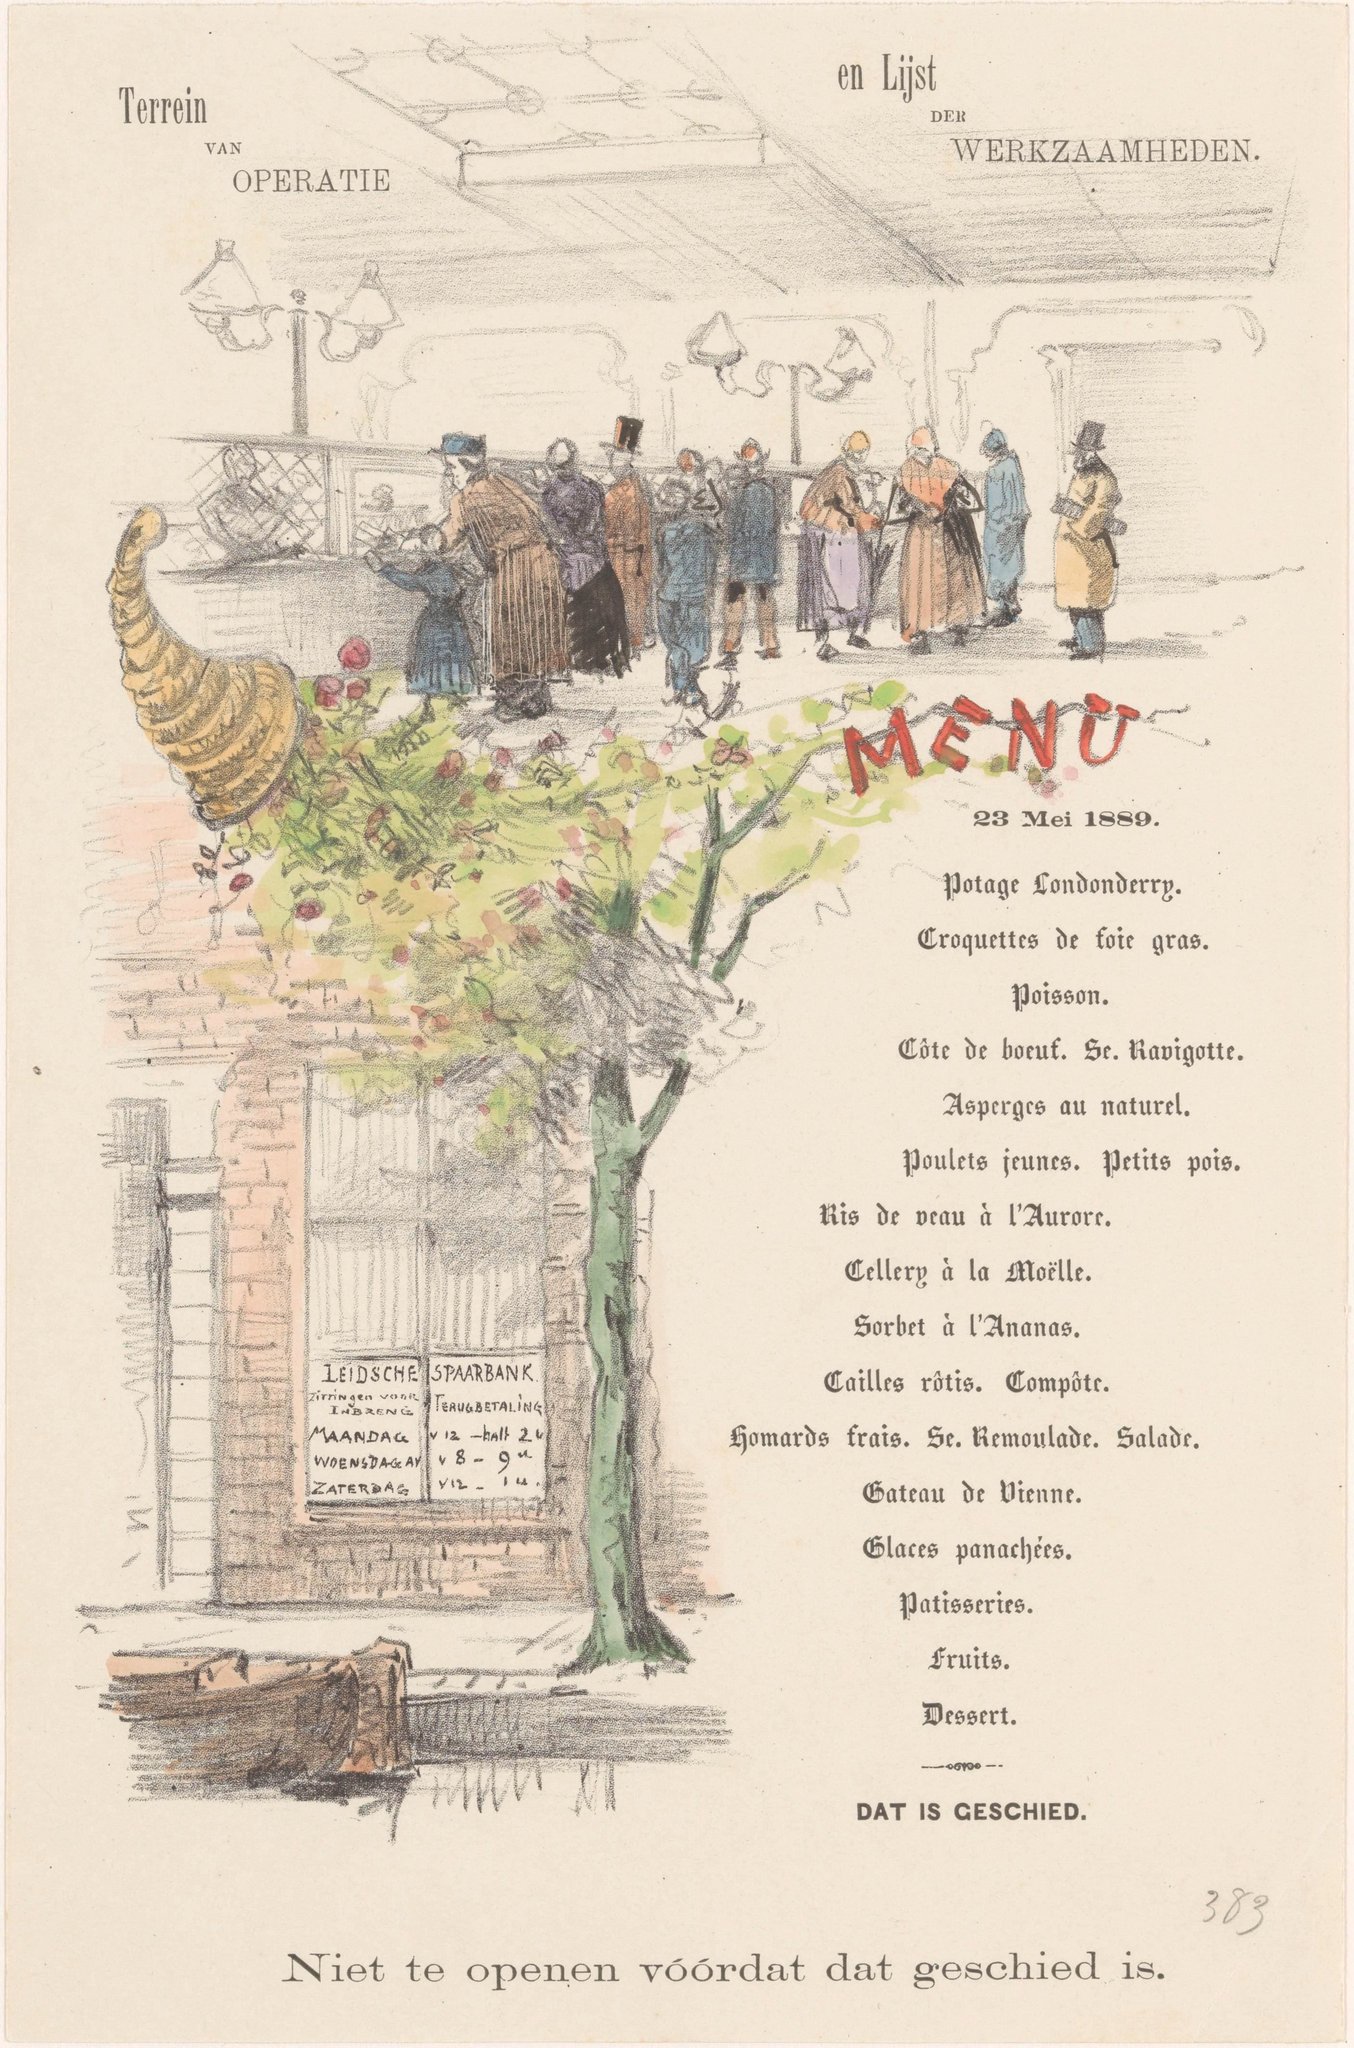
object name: print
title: Menukaart voor de Leidsche spaarbank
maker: theo van hoytema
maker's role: draughtsman, painter, print maker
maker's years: 1863-1917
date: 1805-1889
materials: paper, watercolor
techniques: hand coloring, letterpress printing, lithograph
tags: 'cornucopia', horn of plenty, bank, leiden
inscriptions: collector's mark: Lugt 2228, number: ‘383’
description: Bovenaan staan mensen bij loketten. Rechts het woord menu en een lijst met gerechten. Linksonder een venster met het opschrift 'Leidsche Spaarbank'.